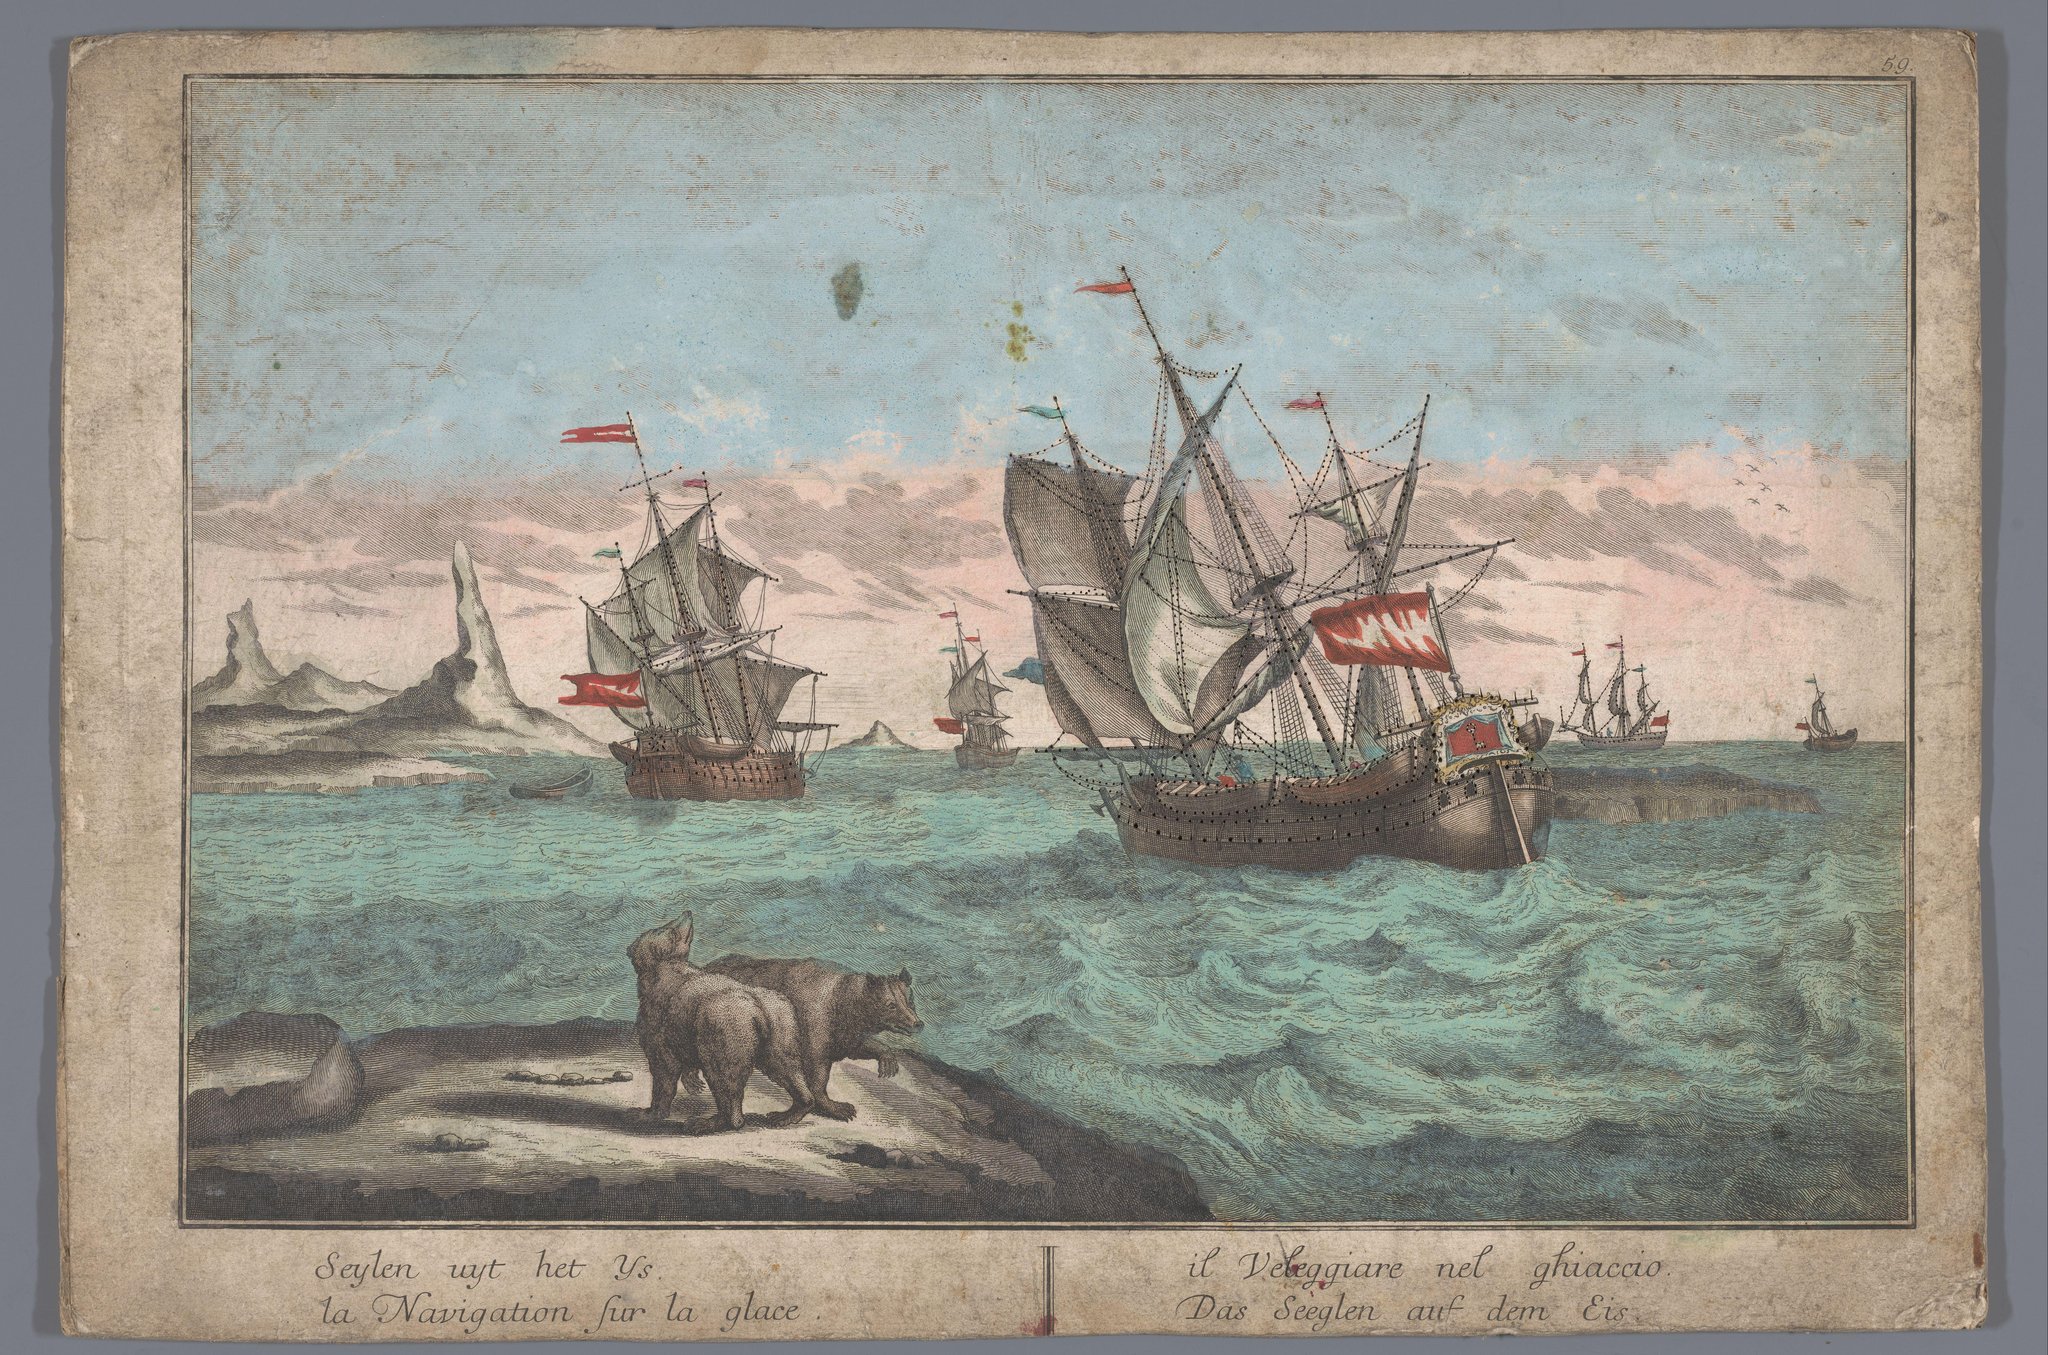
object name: print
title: Das Seeglen auf dem Eis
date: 1742-1801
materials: cardboard, paint, paper, watercolor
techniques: brush, cutting, etching, perforating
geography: augsburg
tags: beasts of prey, predatory animals: polar bear, sailing-ship, sailing-boat, landscapes in polar regions, whale fishery, whaling, sea (seascape) (+ landscape with figures, staffage), greenland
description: Mogelijk linksonder genummerd geweest: 3. De serie “Walvisvangst voor Groenland”, met het nummer 3, bevat vier prenten met de nummers 57-60, waarvan dit mogelijk nummer 59 is.